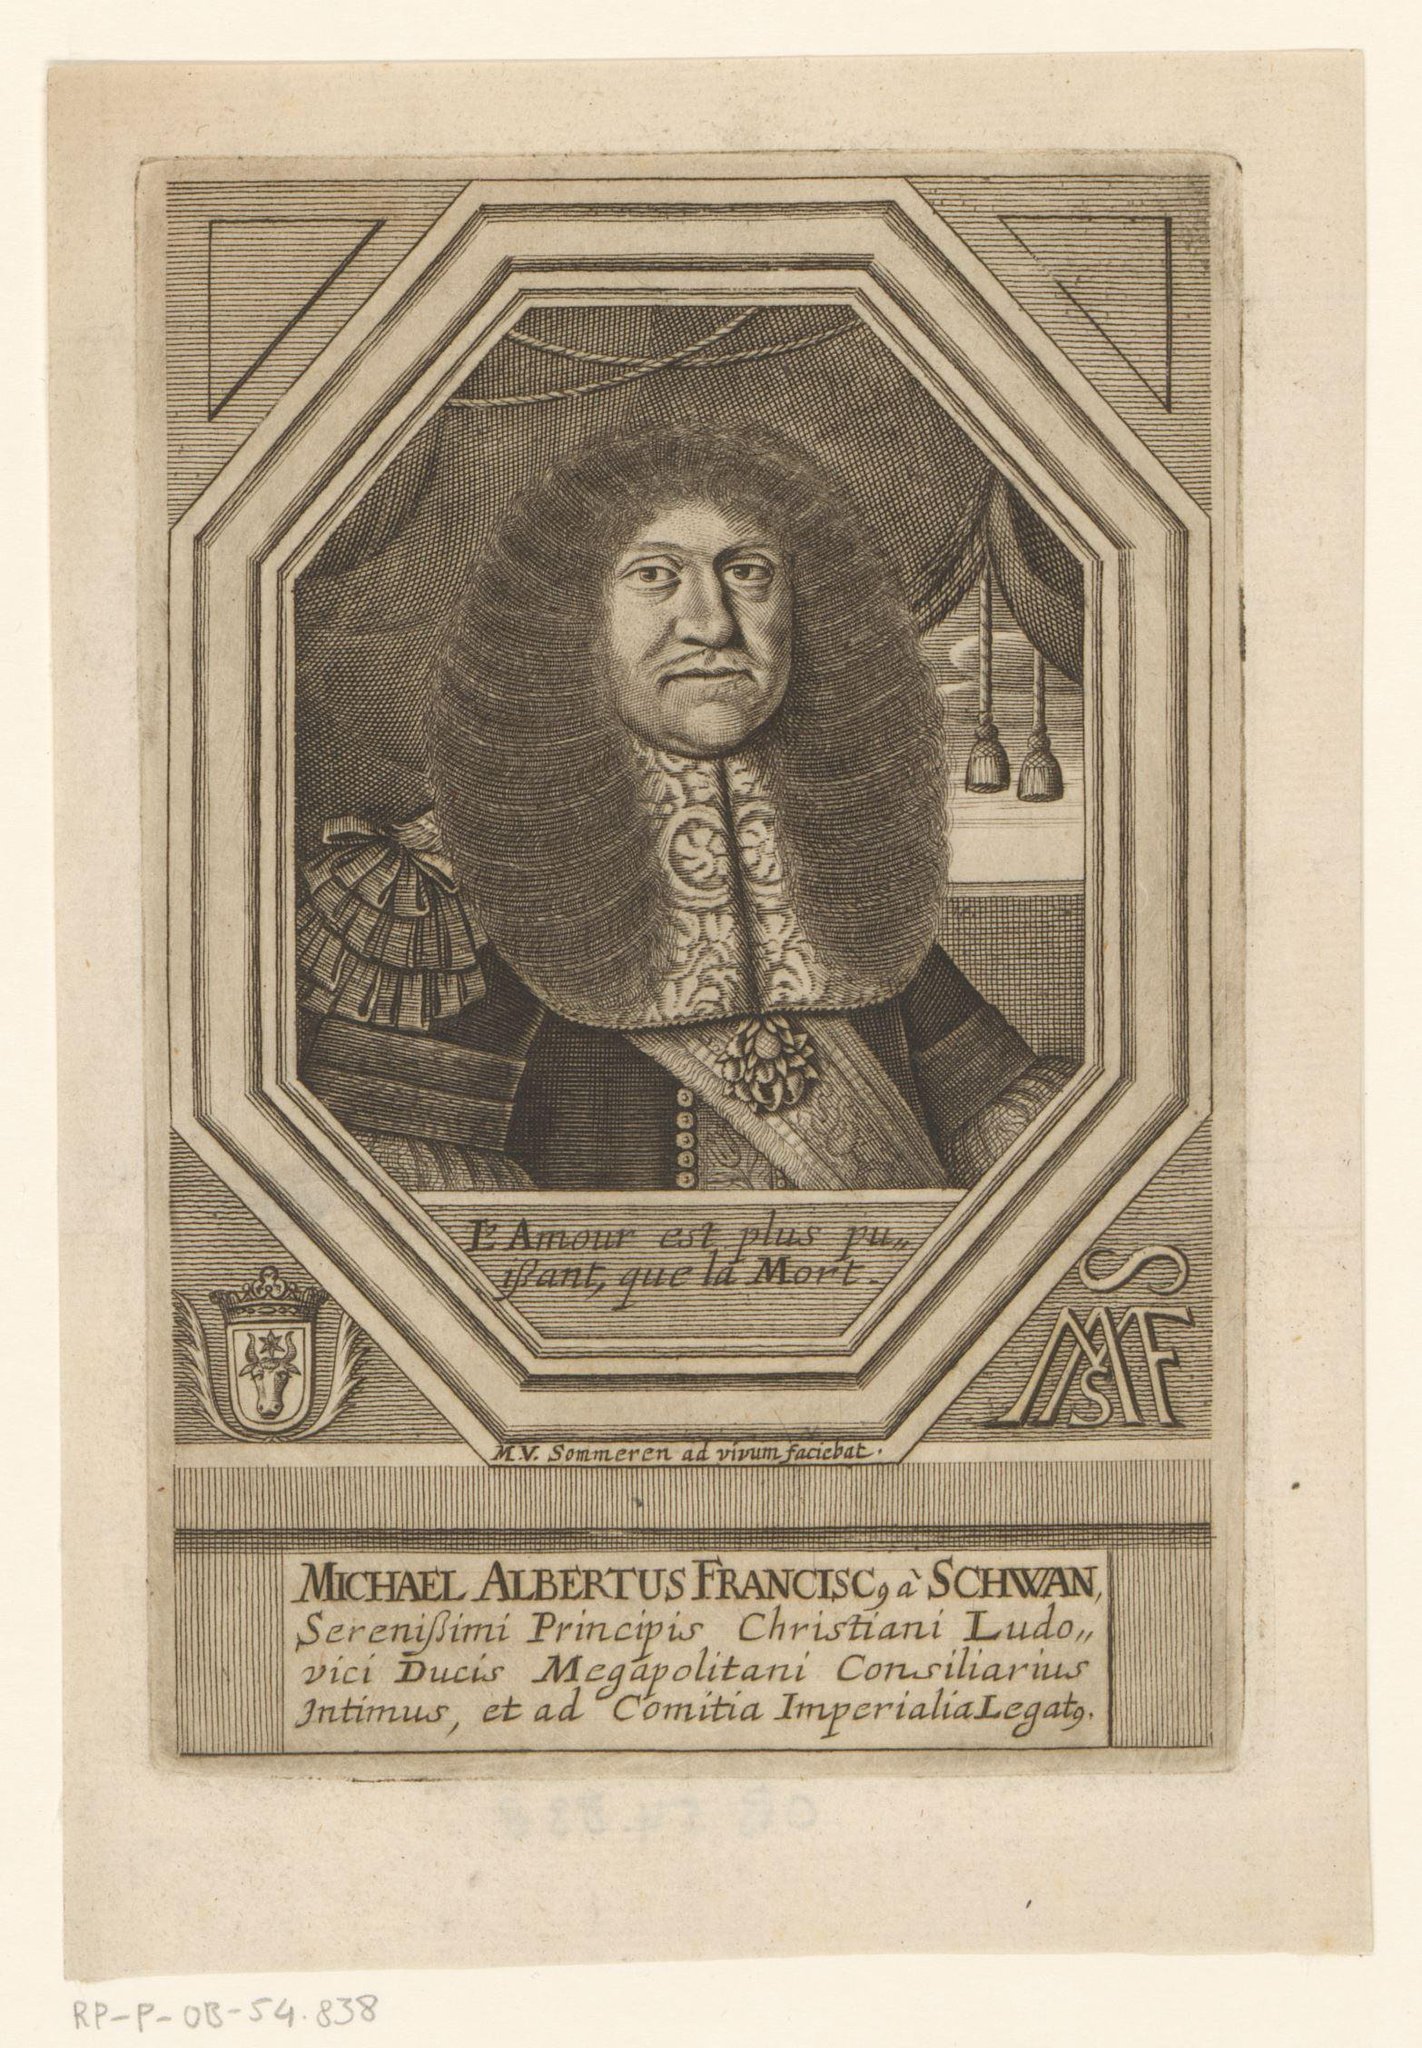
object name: print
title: Portret van Michael Albertus Francis von Schwan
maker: matthias van sommer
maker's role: draughtsman, print maker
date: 1667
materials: paper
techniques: engraving, etching, intaglio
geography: germany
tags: historical persons, armorial bearing, heraldry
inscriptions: collector's mark: Lugt 2228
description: Volgens Hollstein werd de prent gebruikt voor de publicatie: Sommer, Matthias van. Hasce Omnium Electorum. Regensburg: s.n., 1667. Alhoewel op de titelpagina van de publicatie het jaar 1667 wordt vermeld, zijn meerdere prenten later gedateerd. Waarschijnlijk werd de publicatie pas in 1671 daadwerkelijk uitgegeven.